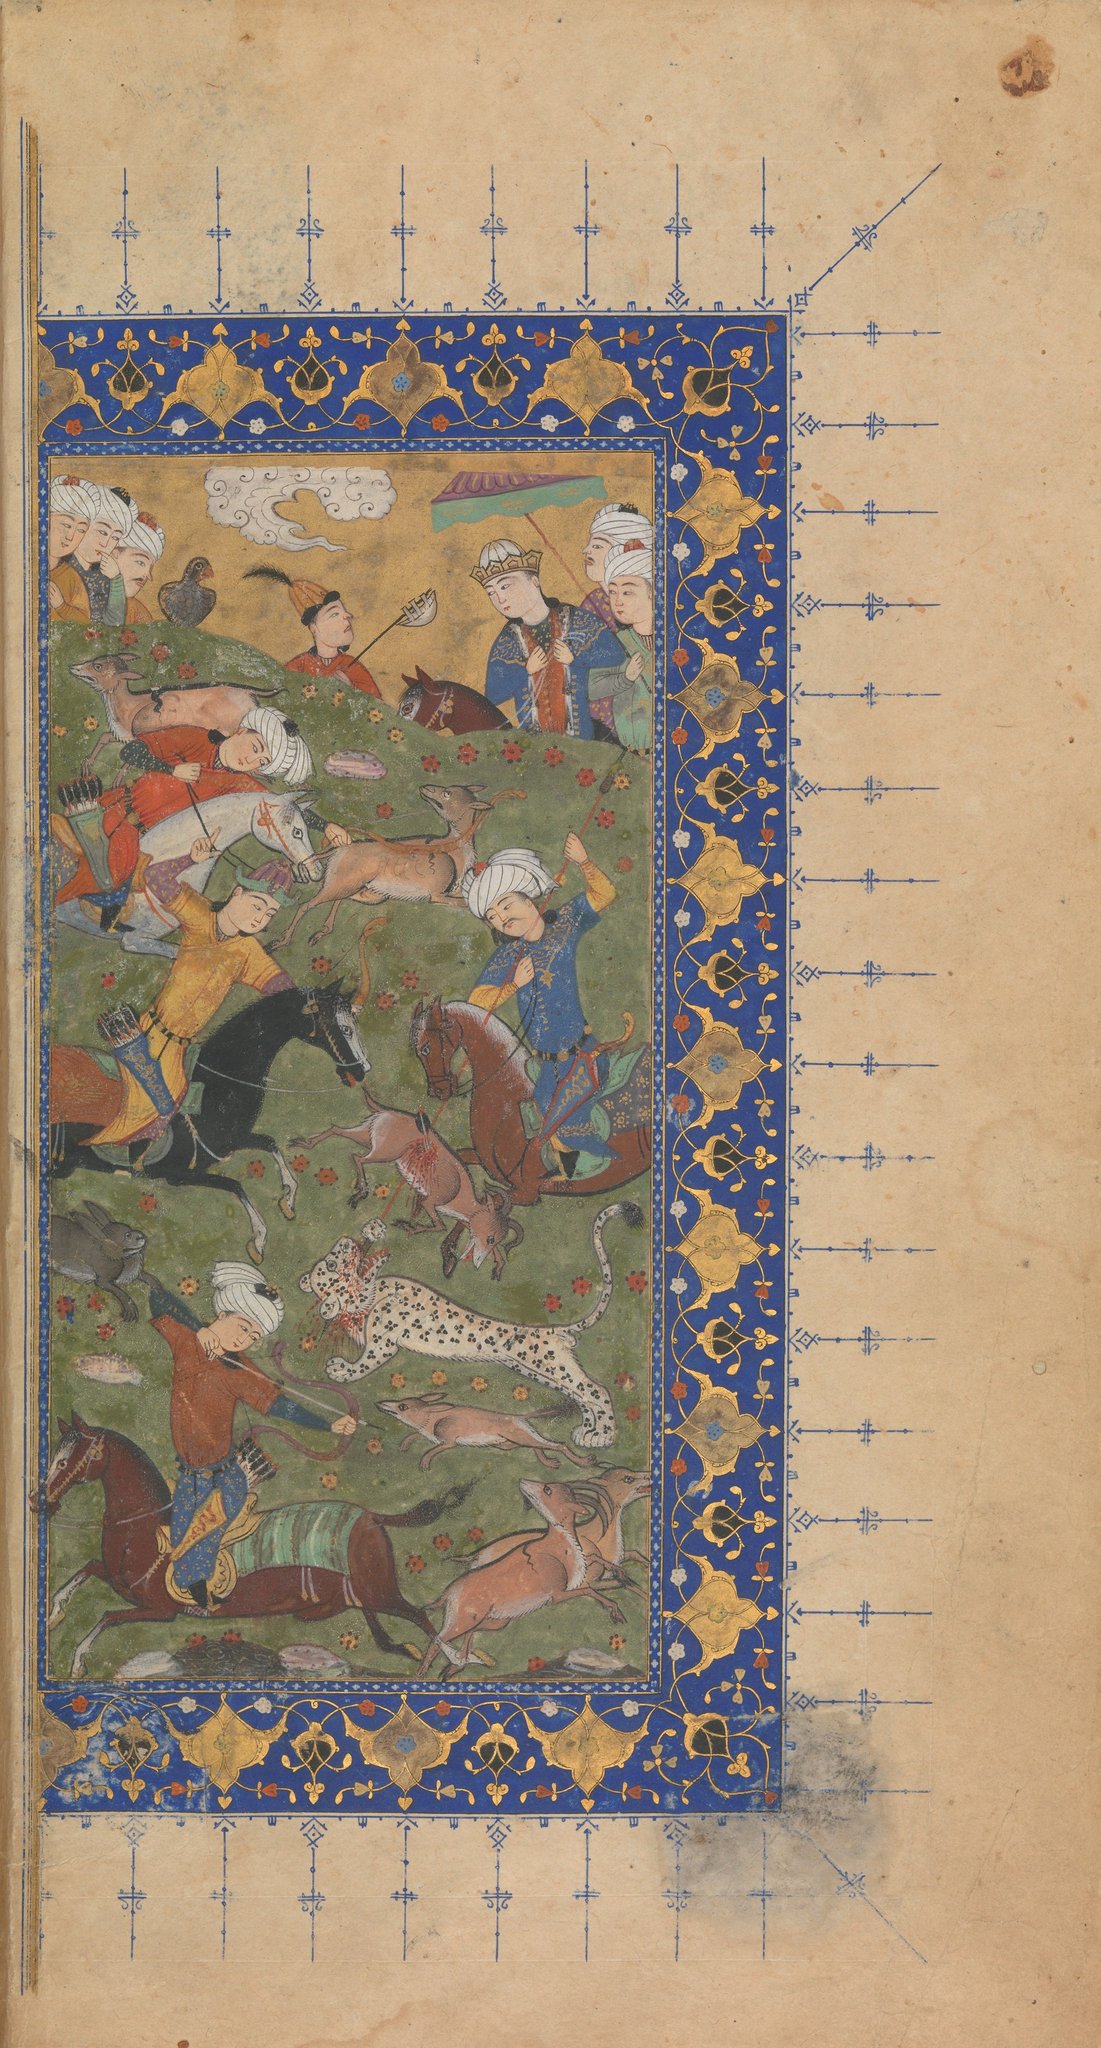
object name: illustrated manuscript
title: Divan (Collected Works) of Jami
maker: maulana nur al-din `abd al-rahman jami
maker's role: author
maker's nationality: iranian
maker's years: 1414-1492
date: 1480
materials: gold, ink, leather, paper, watercolor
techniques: bookbinding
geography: iran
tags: animals,men,hunting,horses